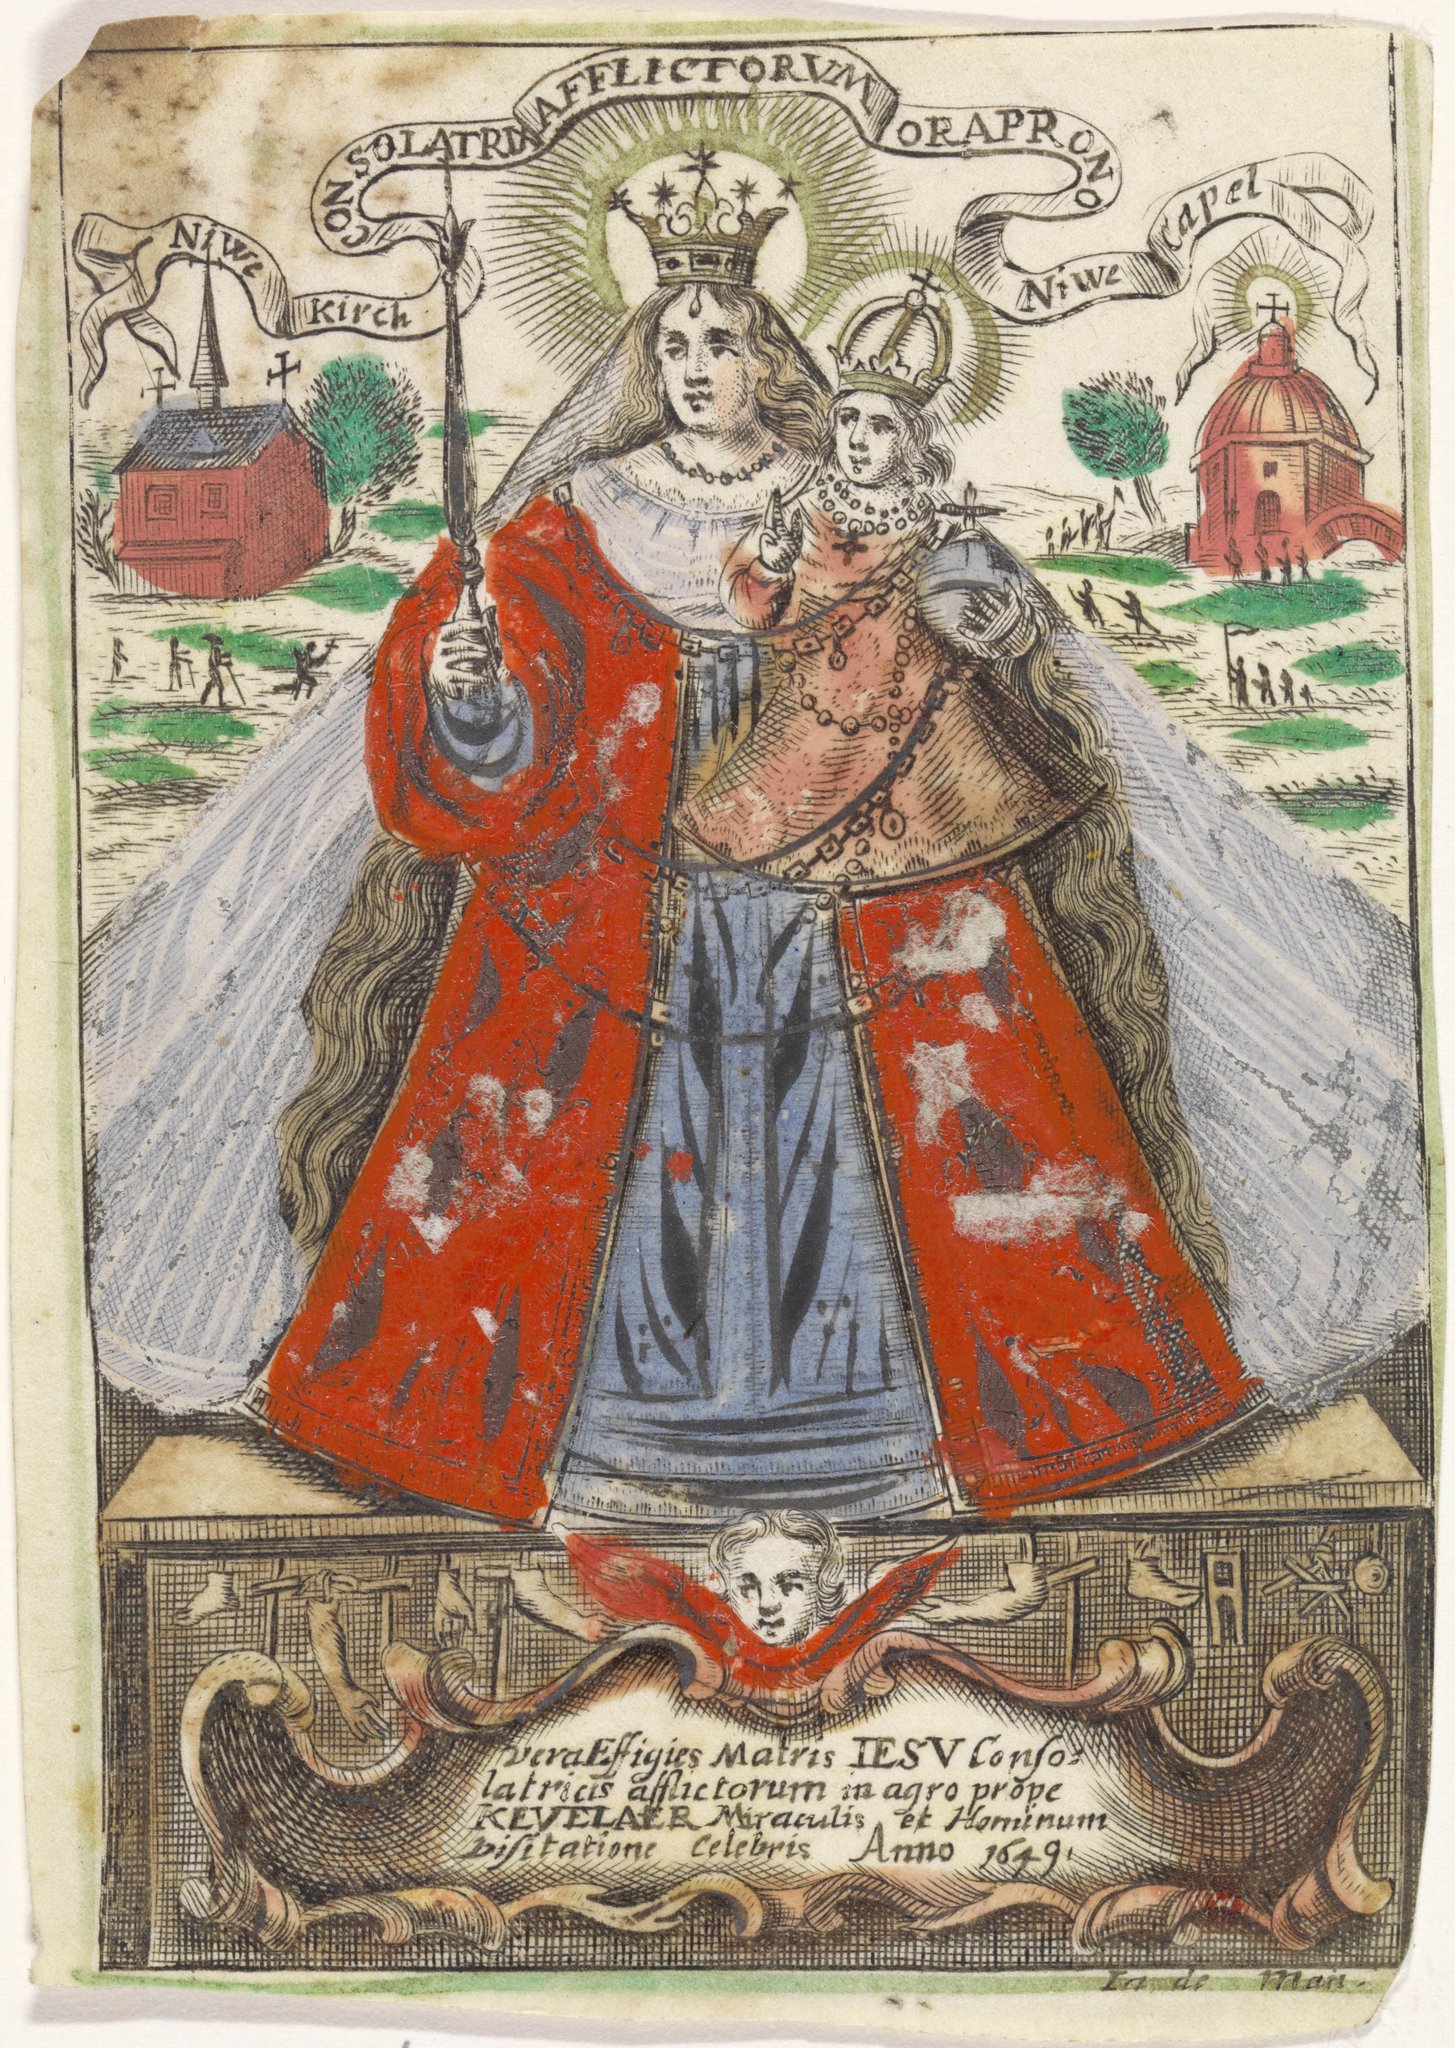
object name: print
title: Maria met Kind met achter haar twee kerkgebouwen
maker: jacobus de man (i)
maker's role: print maker, publisher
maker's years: 1643-1719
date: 1676-1719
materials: parchment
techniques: brush, engraving, hand coloring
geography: antwerp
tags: mary standing (or half-length), the christ-child on her arm (christ-child to mary's left)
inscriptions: collector's mark: Lugt 2228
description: Maria met het Christuskind, beiden gekroond, het Christuskind met een rijksappel en Maria met een scepter. Bovenaan een banderol met tekst in het Latijn. Op de achtergrond een landschap met twee kerkgebouwen en figuren. Maria staat op een sokkel, met een cartouche met vier regels in het Latijn en een cherubijn.